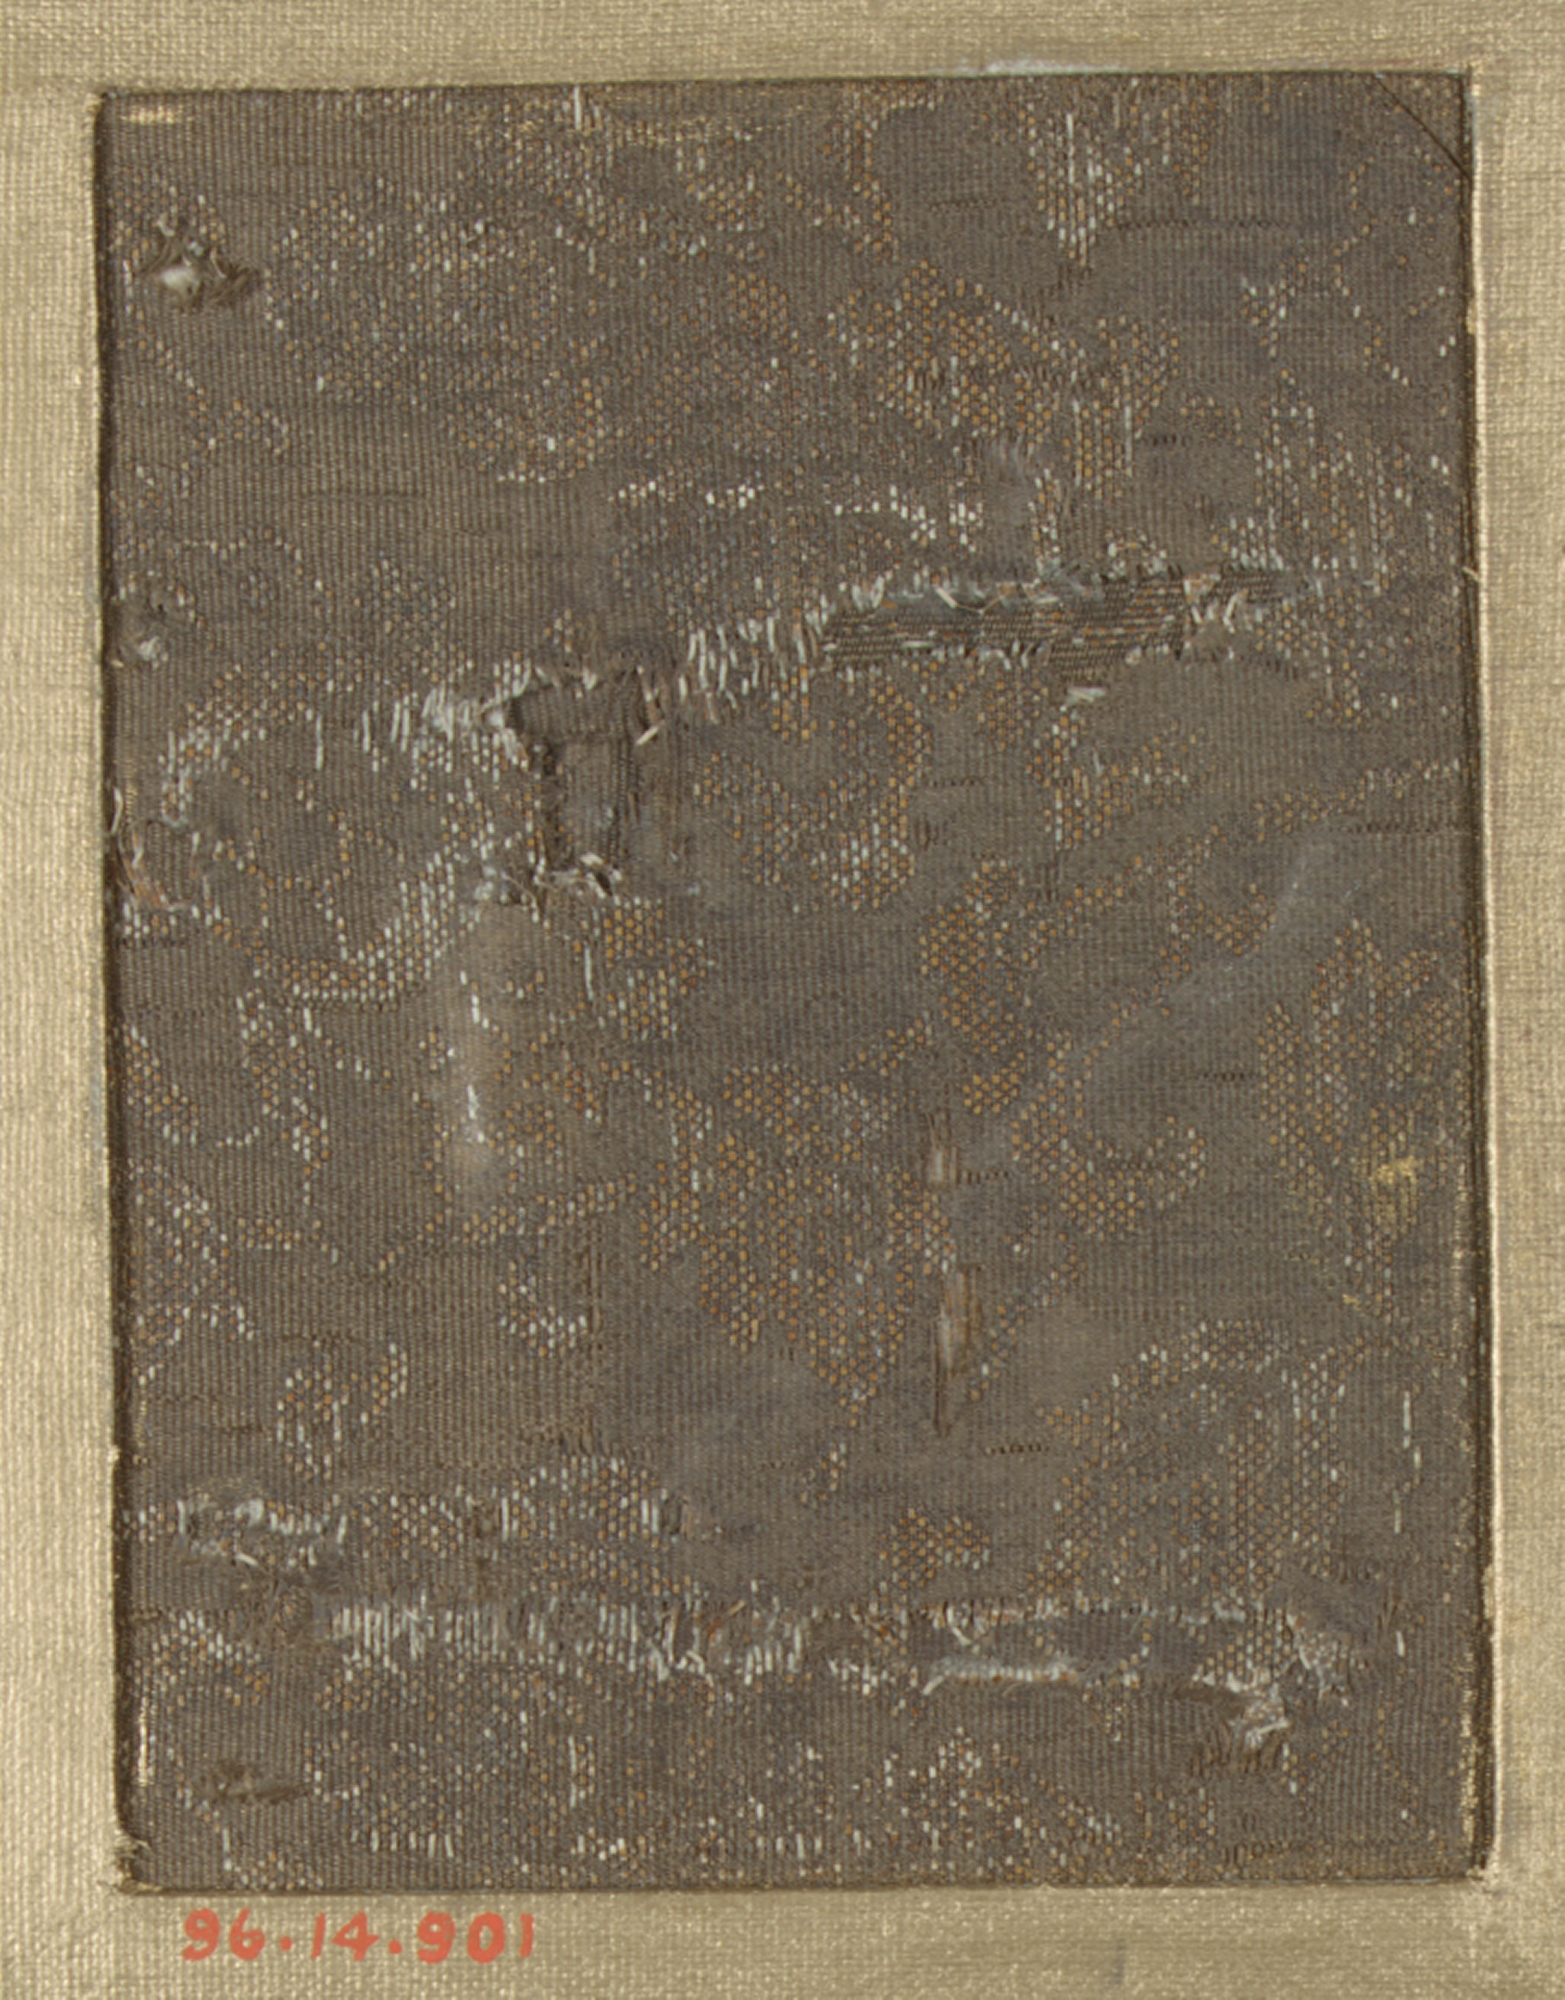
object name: piece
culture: japanese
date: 1701-1900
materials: silk